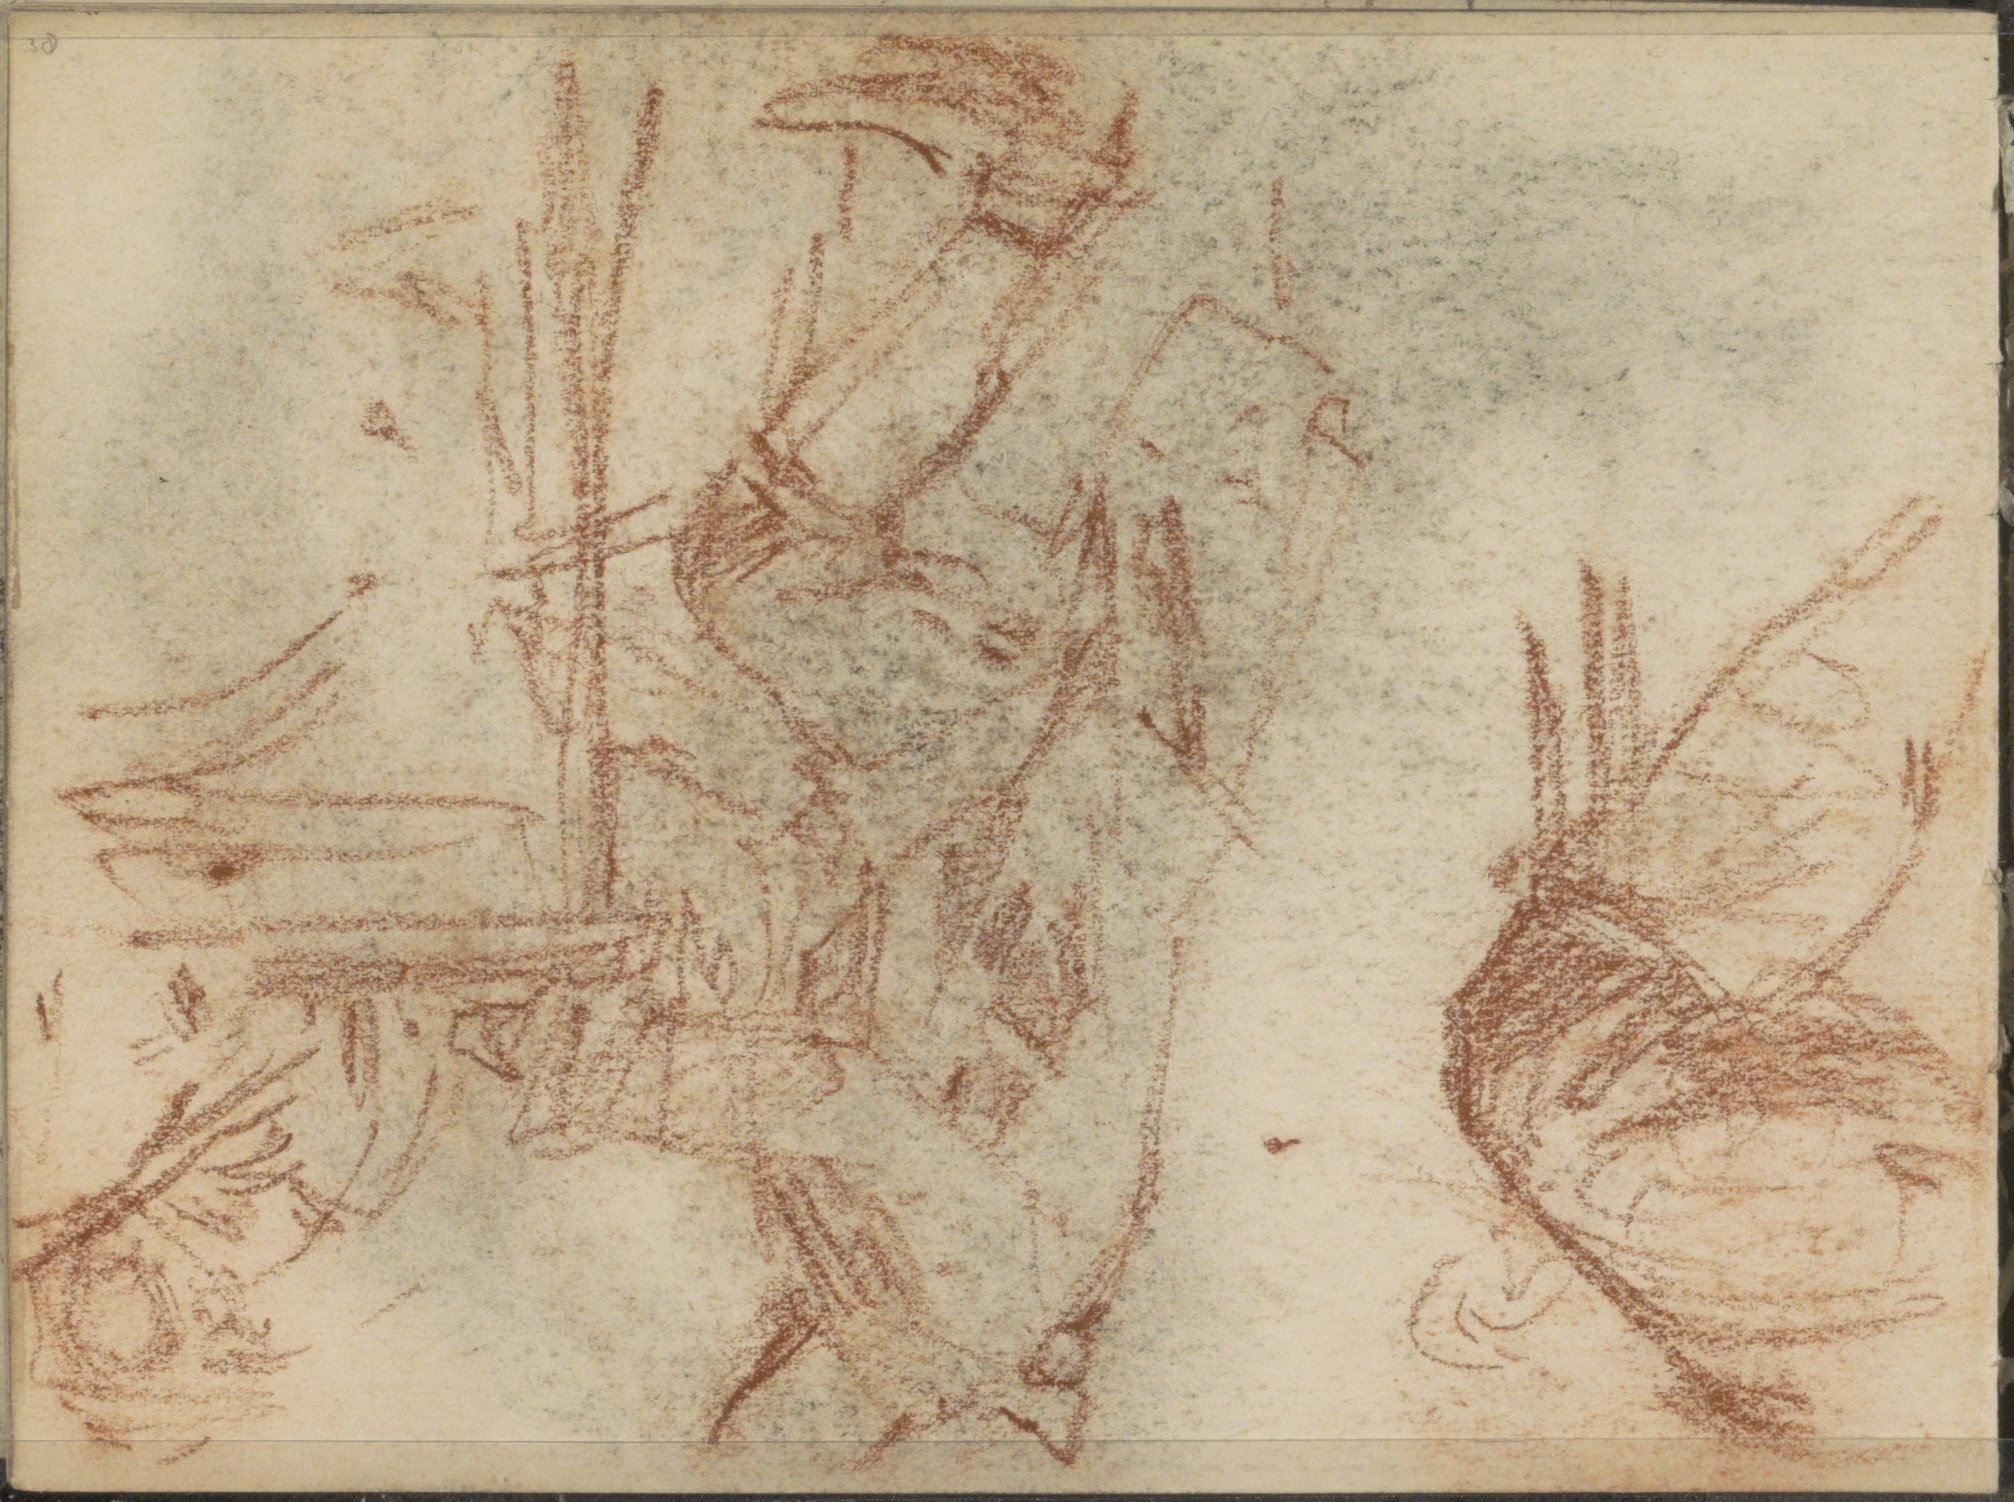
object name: sketchbook leaf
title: Man in achttiende-eeuws kostuum aan een tafel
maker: marius bauer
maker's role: draughtsman, print maker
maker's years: 1867-1932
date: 1879-1884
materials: chalk, paper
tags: sitting figure, adult man, table, historical costume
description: De man is van opzij gezien en zittend getekend. Tevens een studie van been met een halflange broek. Pagina 38 uit een schetsboek met 28 bladen.